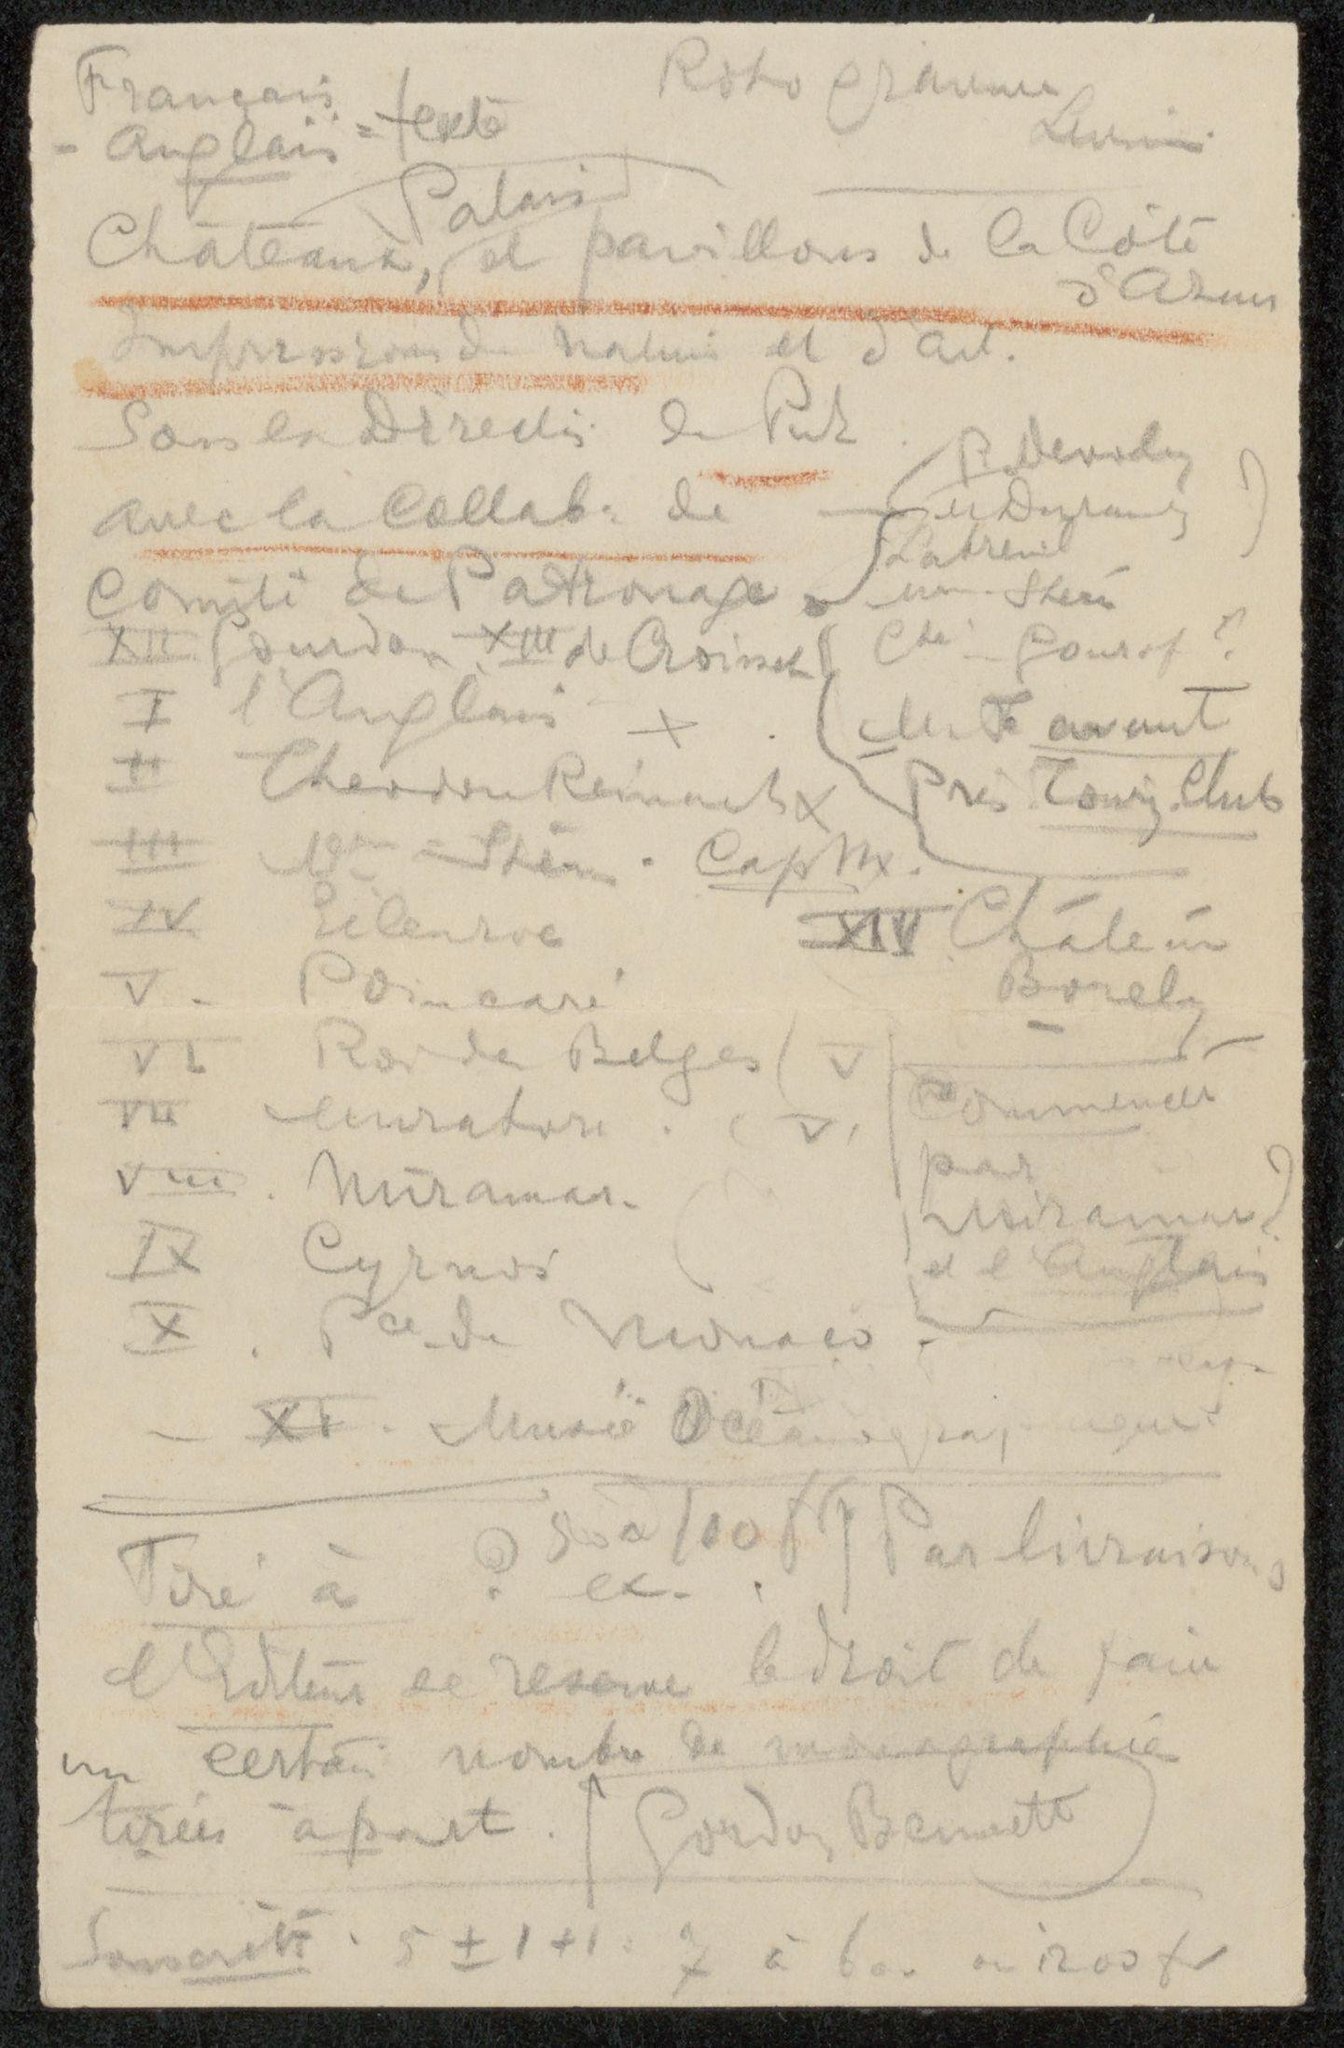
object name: aantekening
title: Aantekeningen uit archief Philip Zilcken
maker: philip zilcken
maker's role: draughtsman, painter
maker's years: 1857-1930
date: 1867-1930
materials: paper, pencil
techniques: writing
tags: the hague, painter, draughtsman, philip zilcken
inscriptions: collector's mark: ‘RPK’